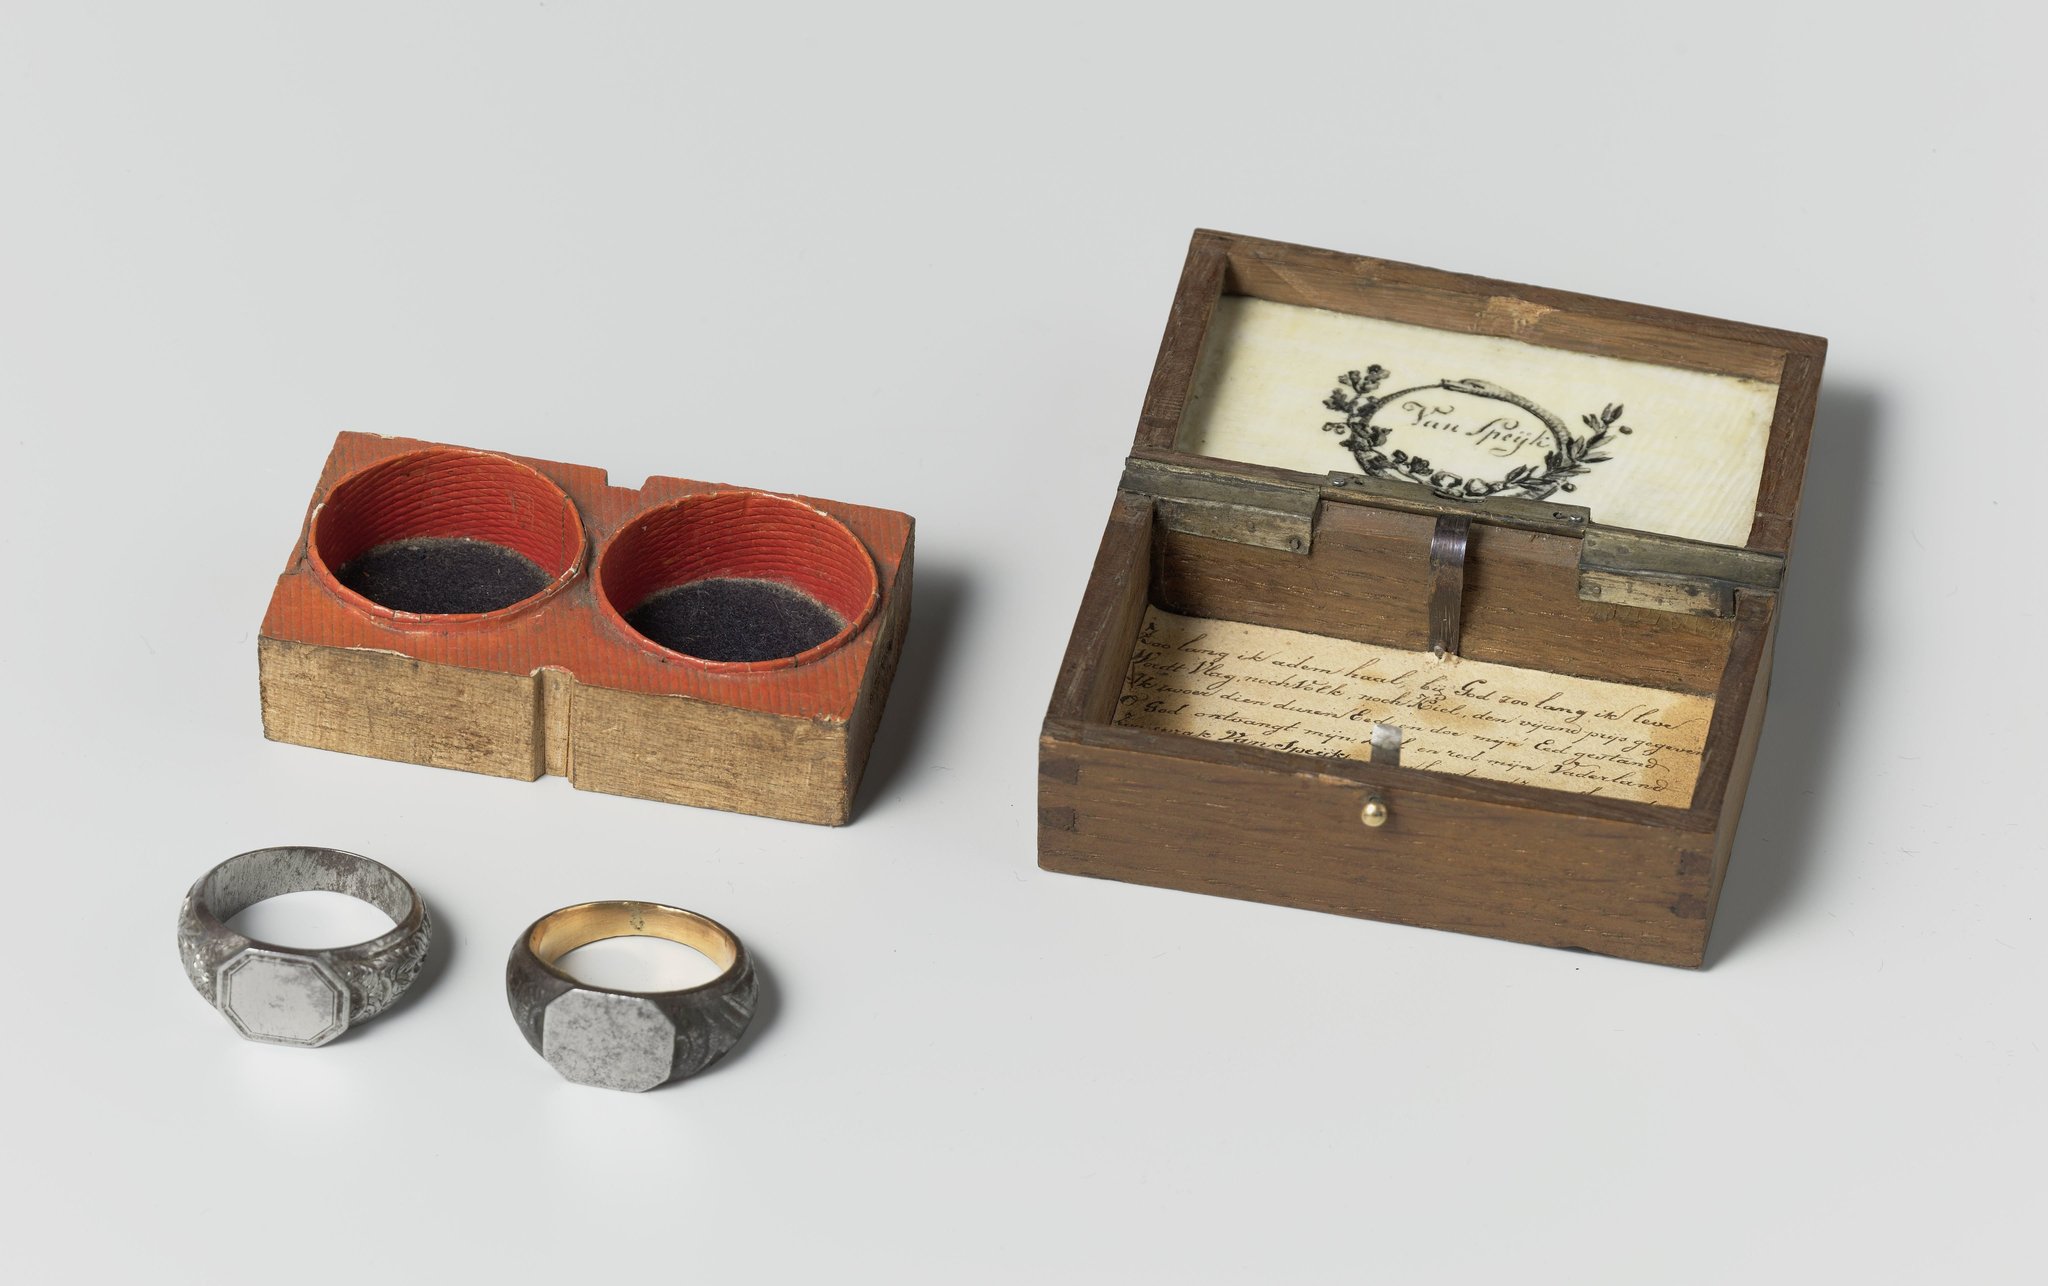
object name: ring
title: Oak box with mementos of Jan van Speijk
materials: copper, gold, steel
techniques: forging, striking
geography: antwerp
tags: amsterdam, antwerp, jan van speyk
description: Stalen vingerring met achthoekig plat gedeelte, aan weerszijden daarvan versierd met plantmotieven, de binnenzijde van de ring is van geel metaal (goud of koper). Opmerking; Zie inv. nrs NG-NM-1090-a, c en d.